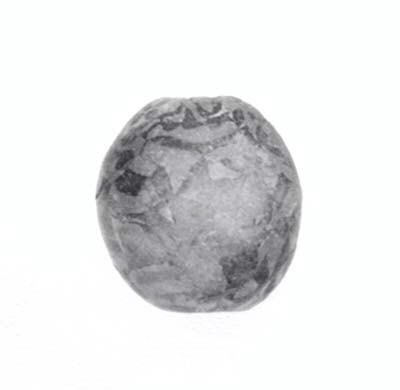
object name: bead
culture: sasanian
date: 201-700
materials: glass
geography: iran